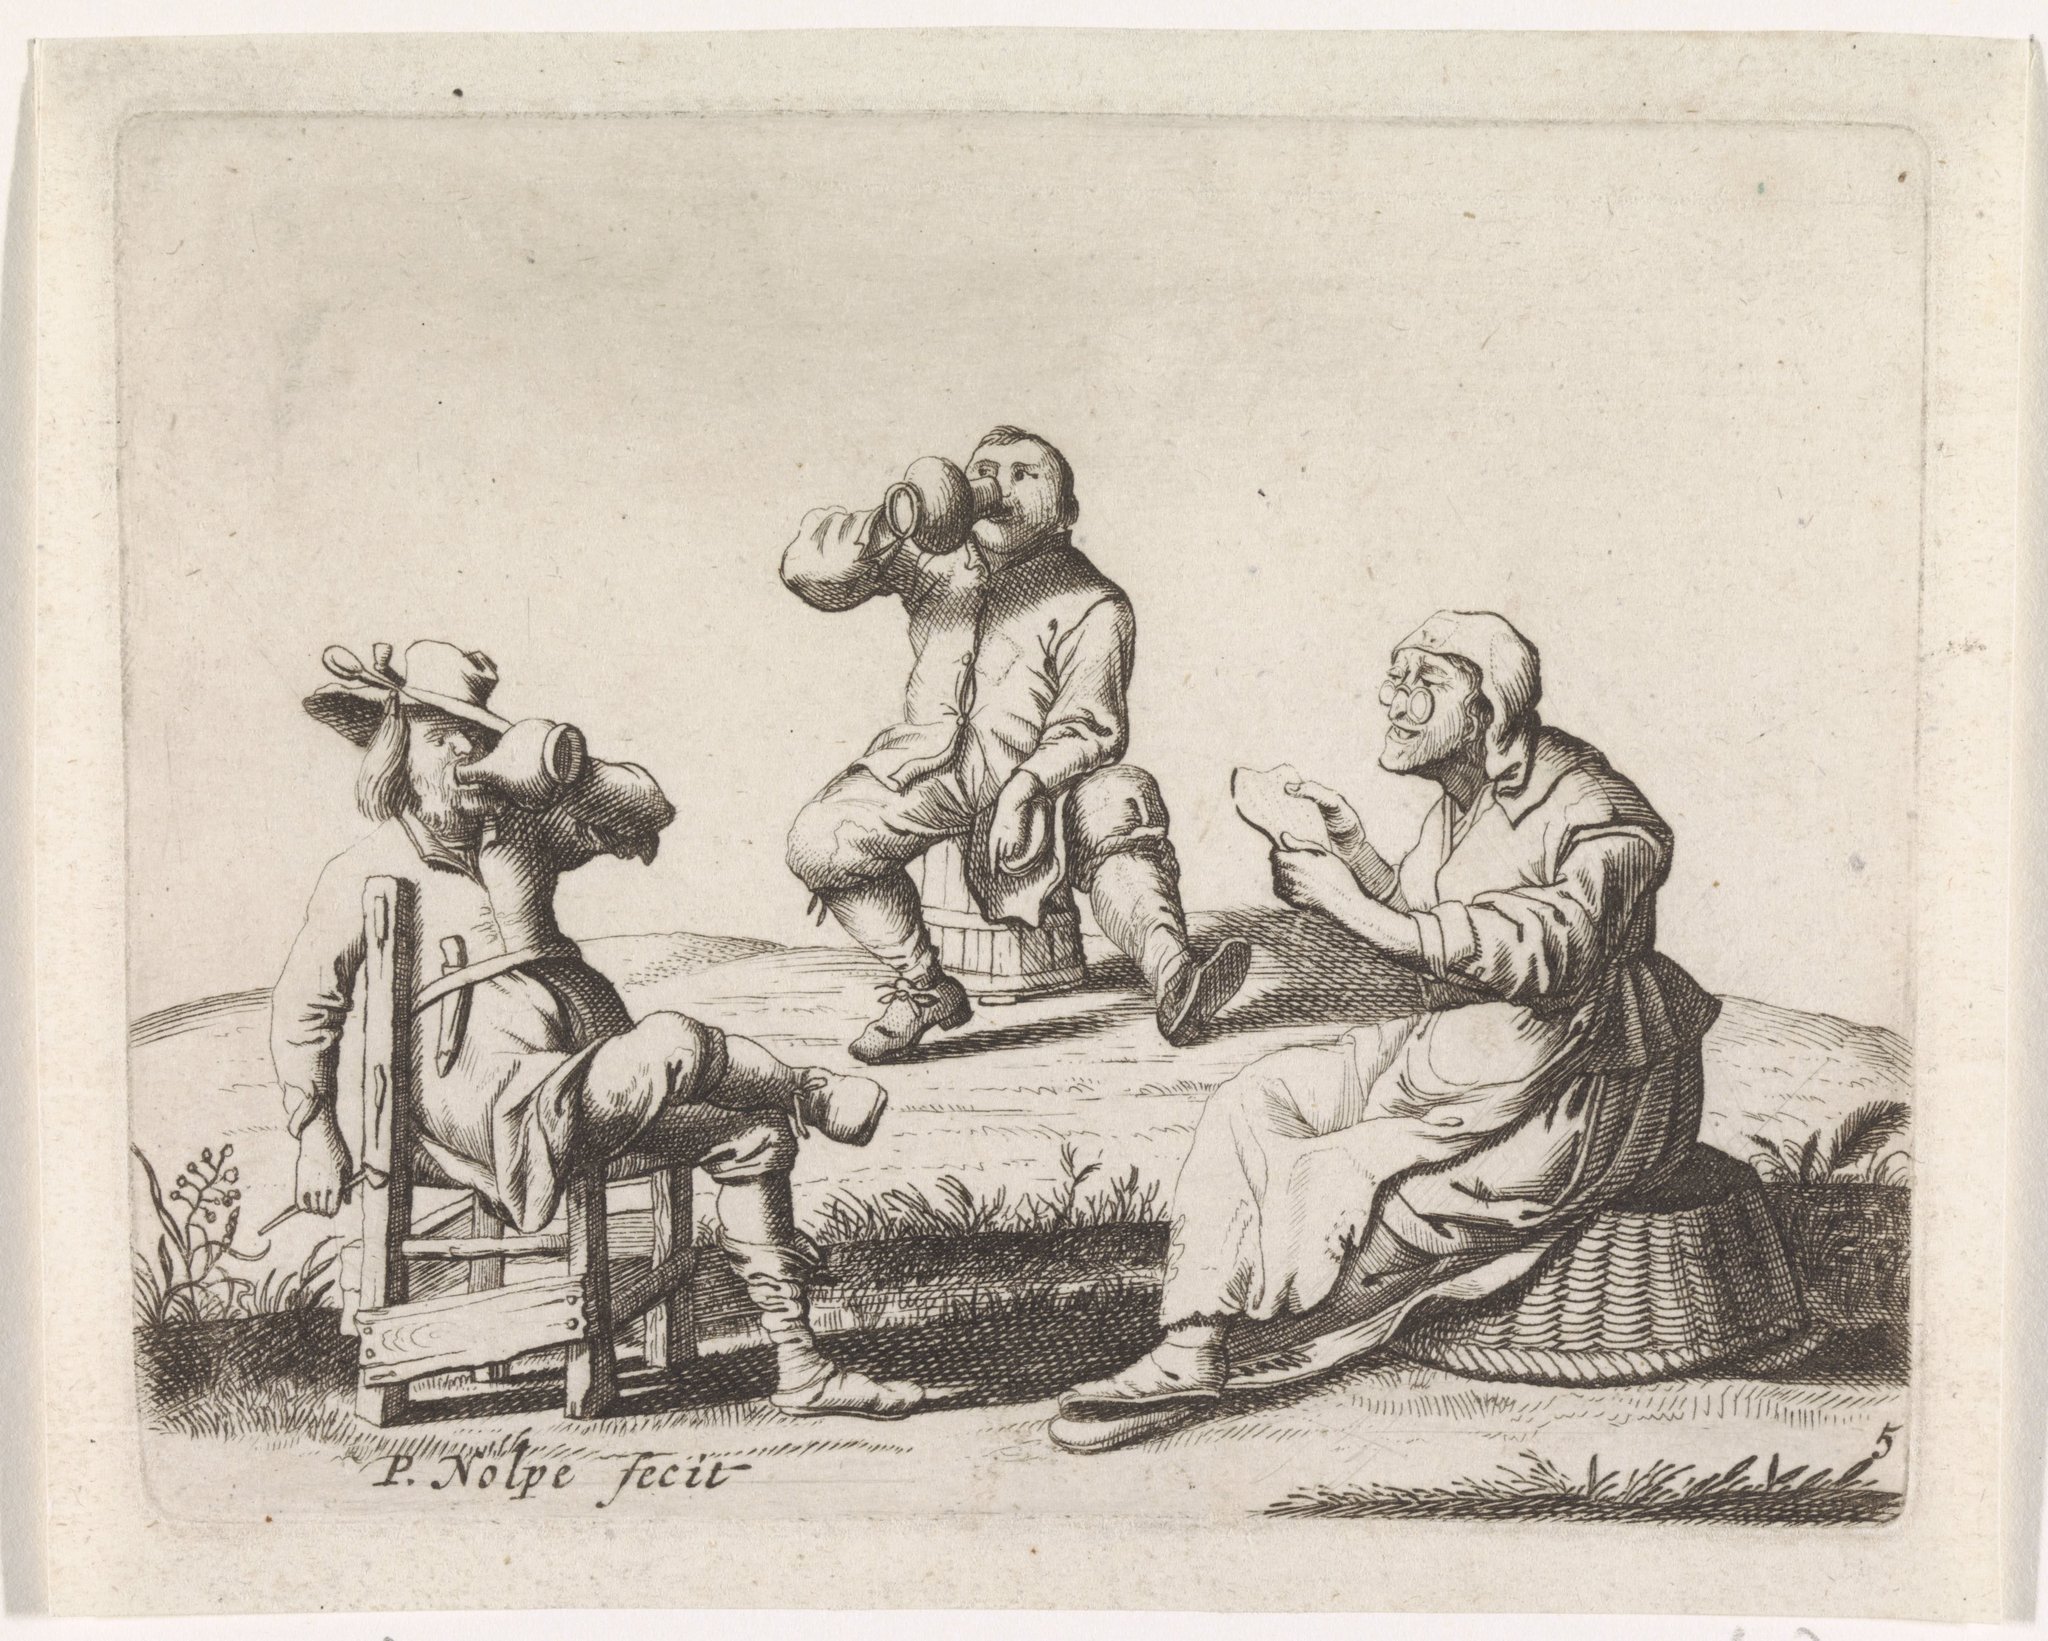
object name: print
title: Drie boeren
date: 1623-1703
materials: paper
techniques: engraving, etching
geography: amsterdam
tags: sitting figure, jar, jug (used as drinking-vessel), farmers, reading to somebody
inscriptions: collector's mark: Lugt 2228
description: Links zit een boer op een stoel, die uit een kruik drinkt. Tegenover hem zit een vrouw op een omgekeerde mand, waar zij met een bril op haar neus voorleest. Middenachter zit een man op een ton, die uit een kruik drinkt en in zijn andere hand zijn hoed houdt.